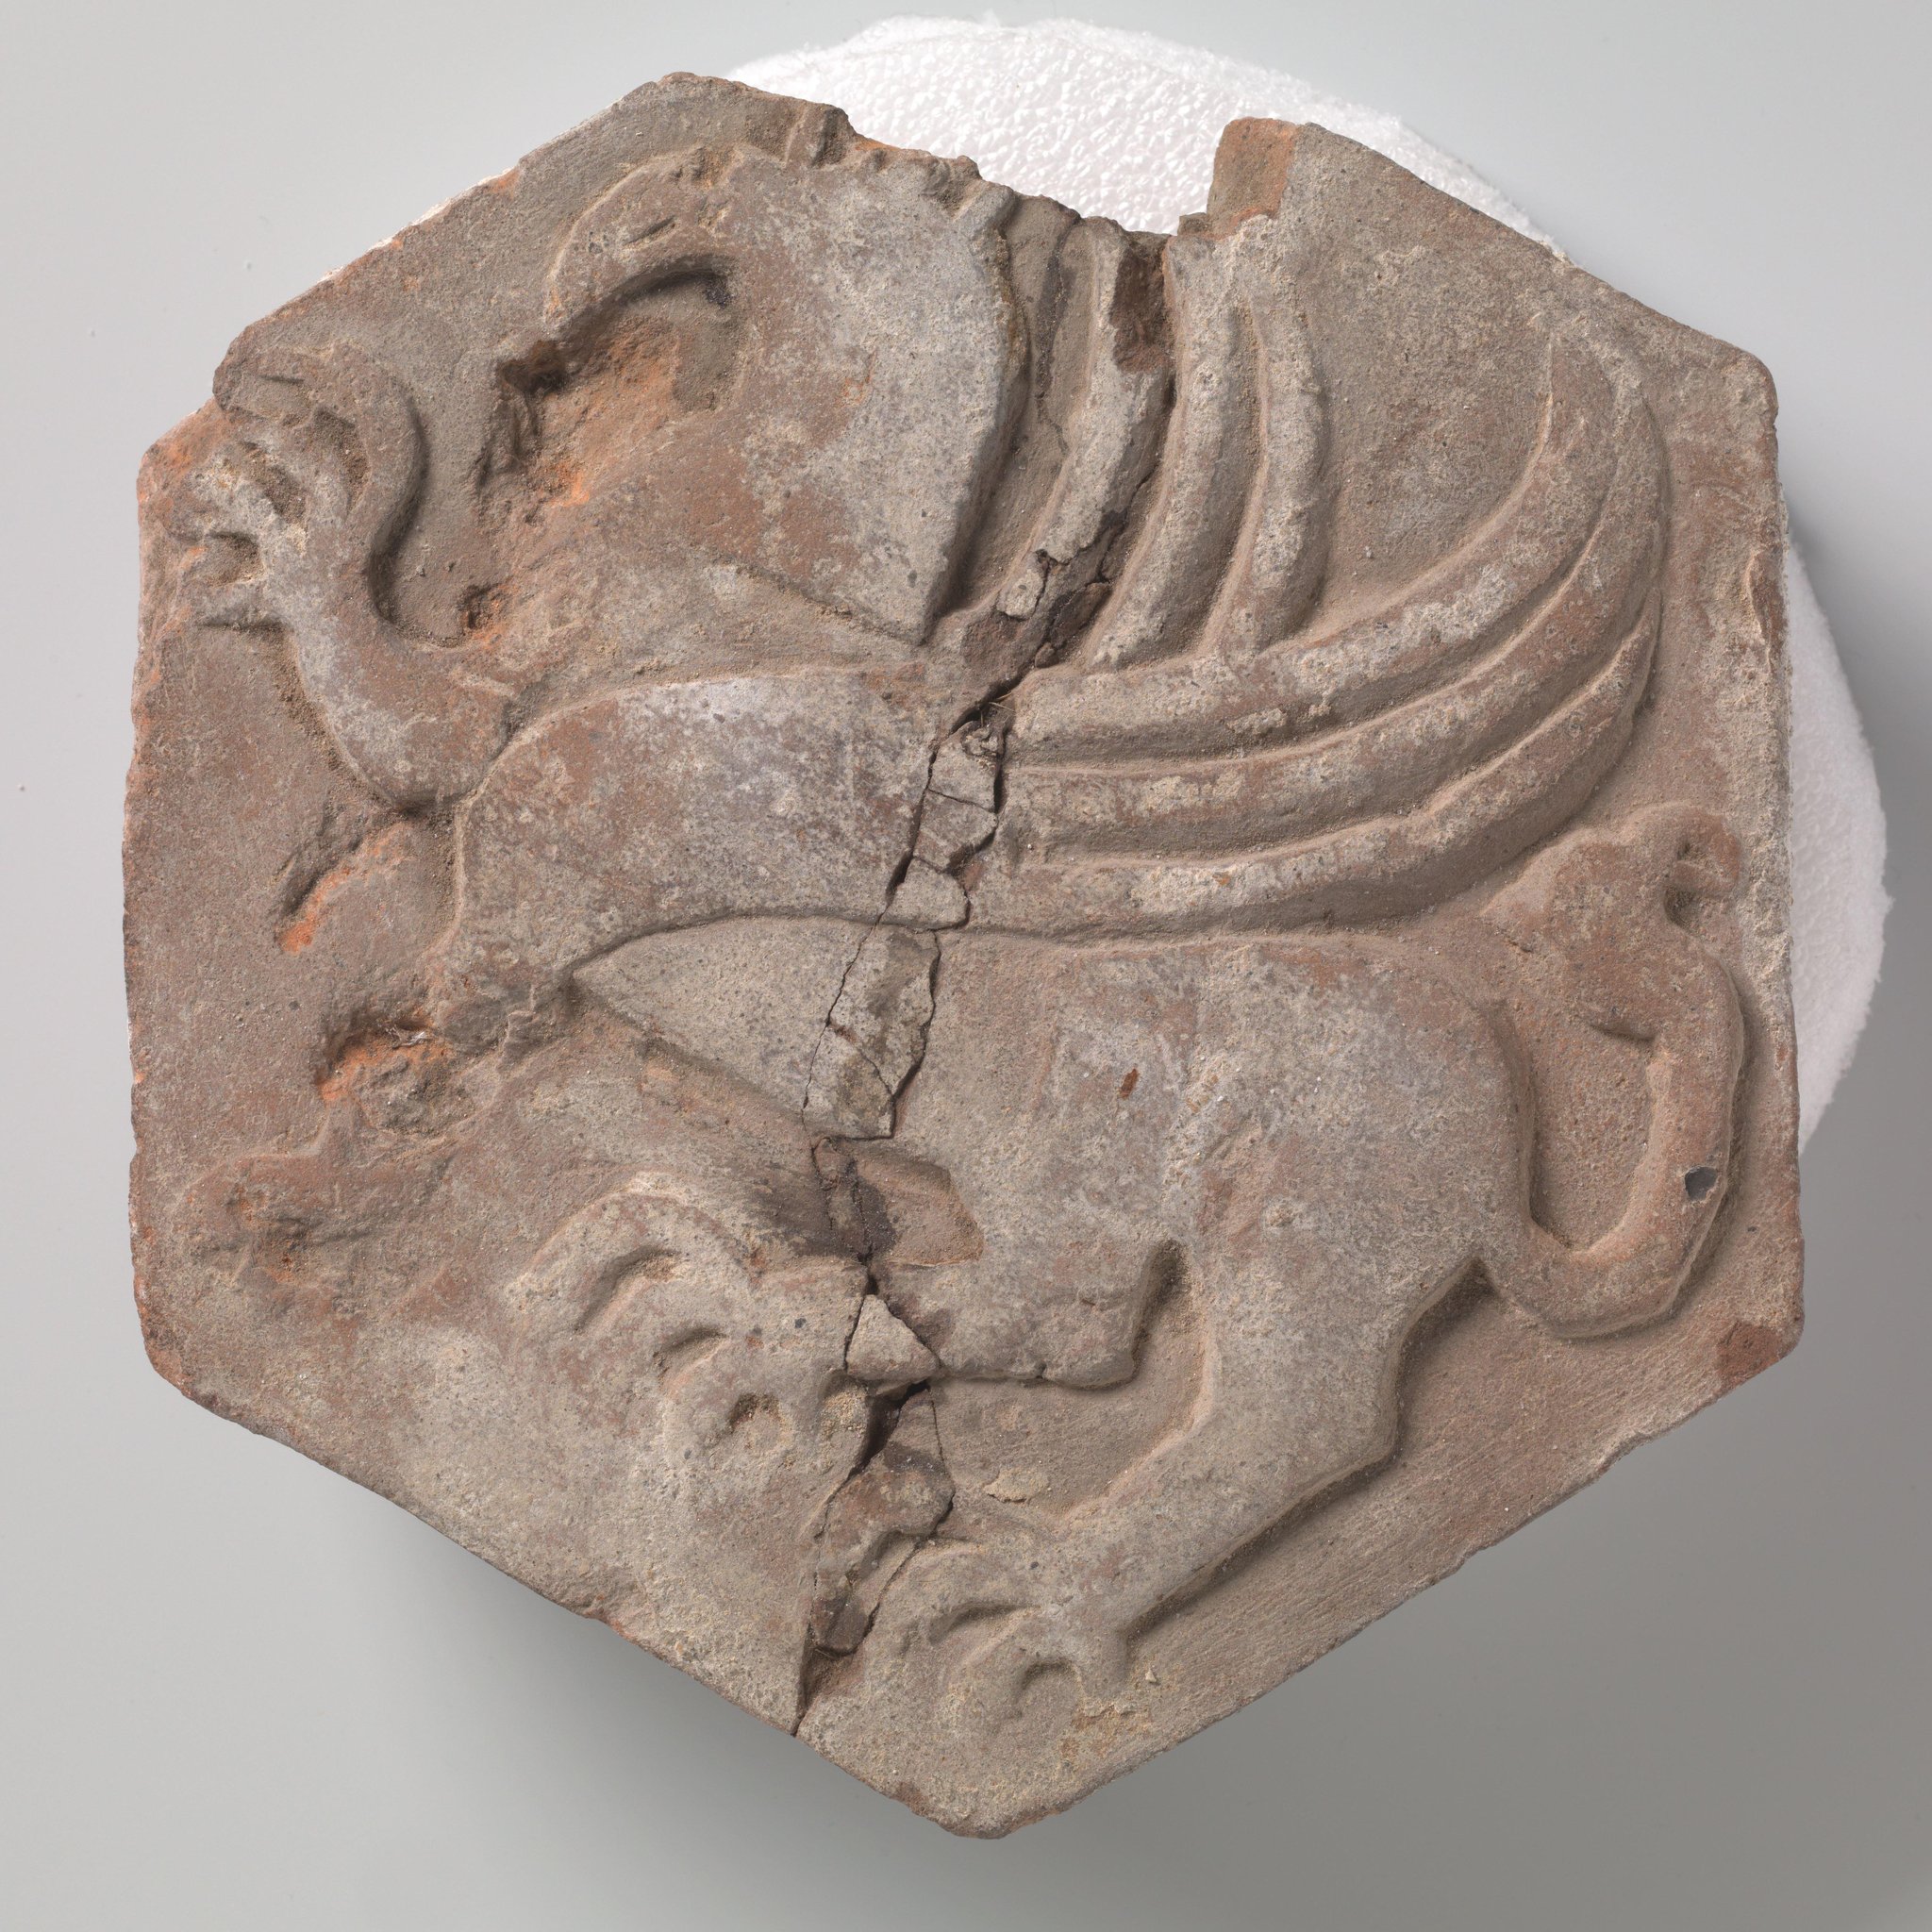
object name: tile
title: Zeskantige tegel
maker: Anonymous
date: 1300-1450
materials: earthenware, glaze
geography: france